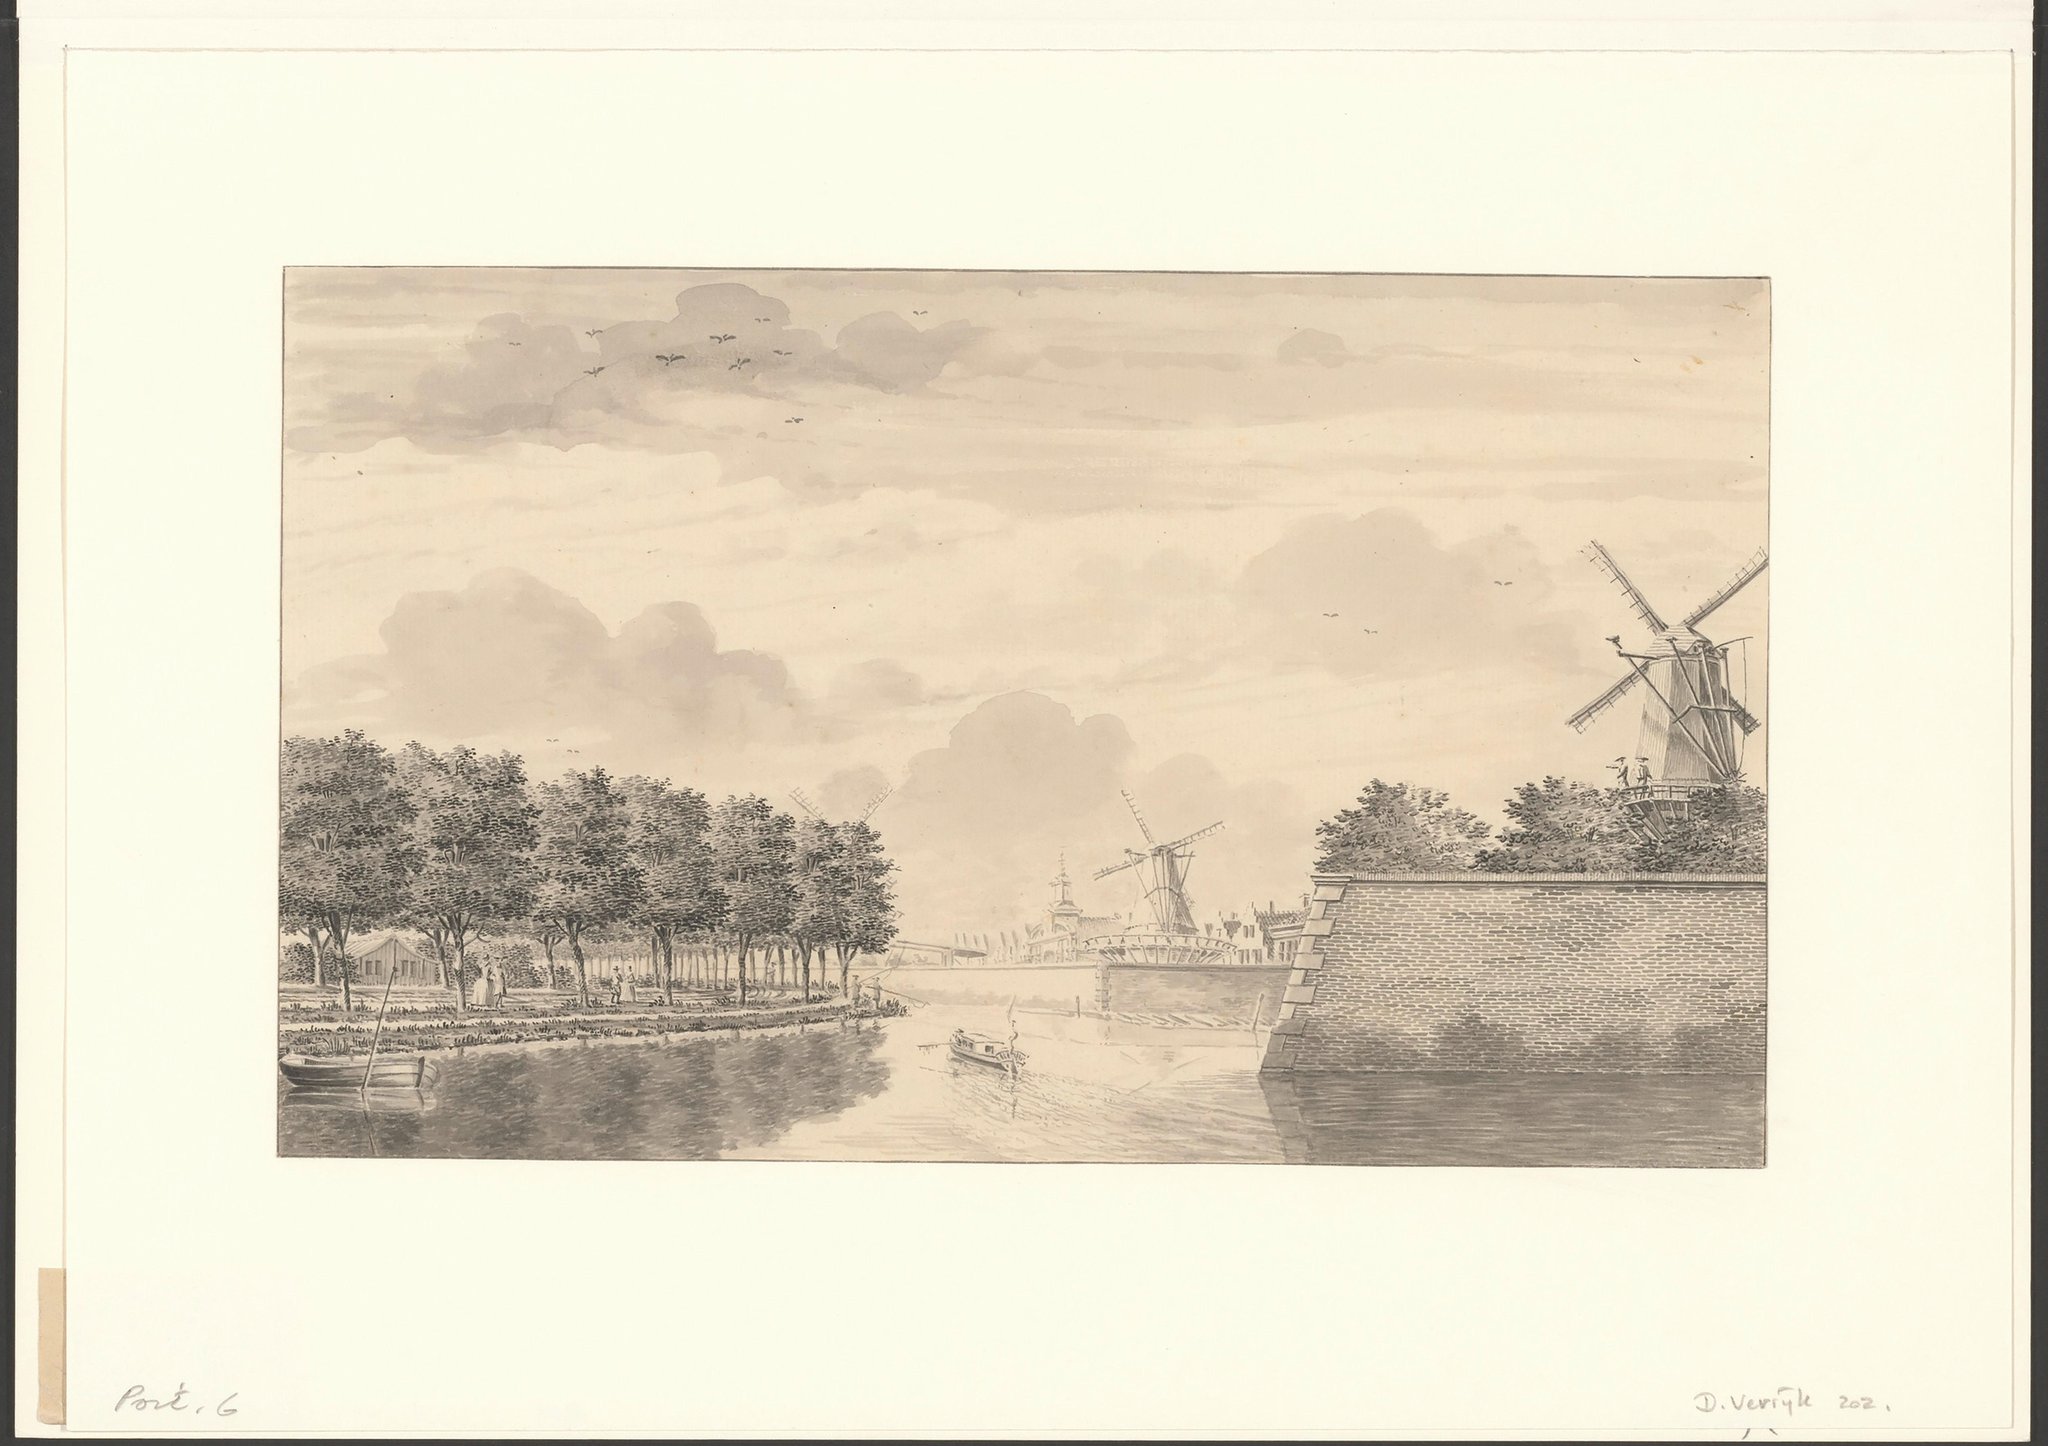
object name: drawing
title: Gezicht op de molens De Koe en De Palm, gezien vanaf het Singel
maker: dirk verrijk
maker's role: draughtsman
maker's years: 1734-1786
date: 1744-1786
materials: ink, paper, pencil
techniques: brush, pen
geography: amsterdam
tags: city-view in general; 'veduta', river, windmill in landscape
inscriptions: inscription: ‘de Molen de Koeij, en de Palm, en haarlemmer" / poort’, inscription: ‘Port. 6’, name: ‘D.Verryk Del ad Viv’, collector's mark: ‘6’ Lugt 1641b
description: Onderwerpsrubriek binnen de Atlas Amsterdam: Buitensingel, Gezichten langs en op de Stadsvest van Haarlemmerpoort tot Raampoort.